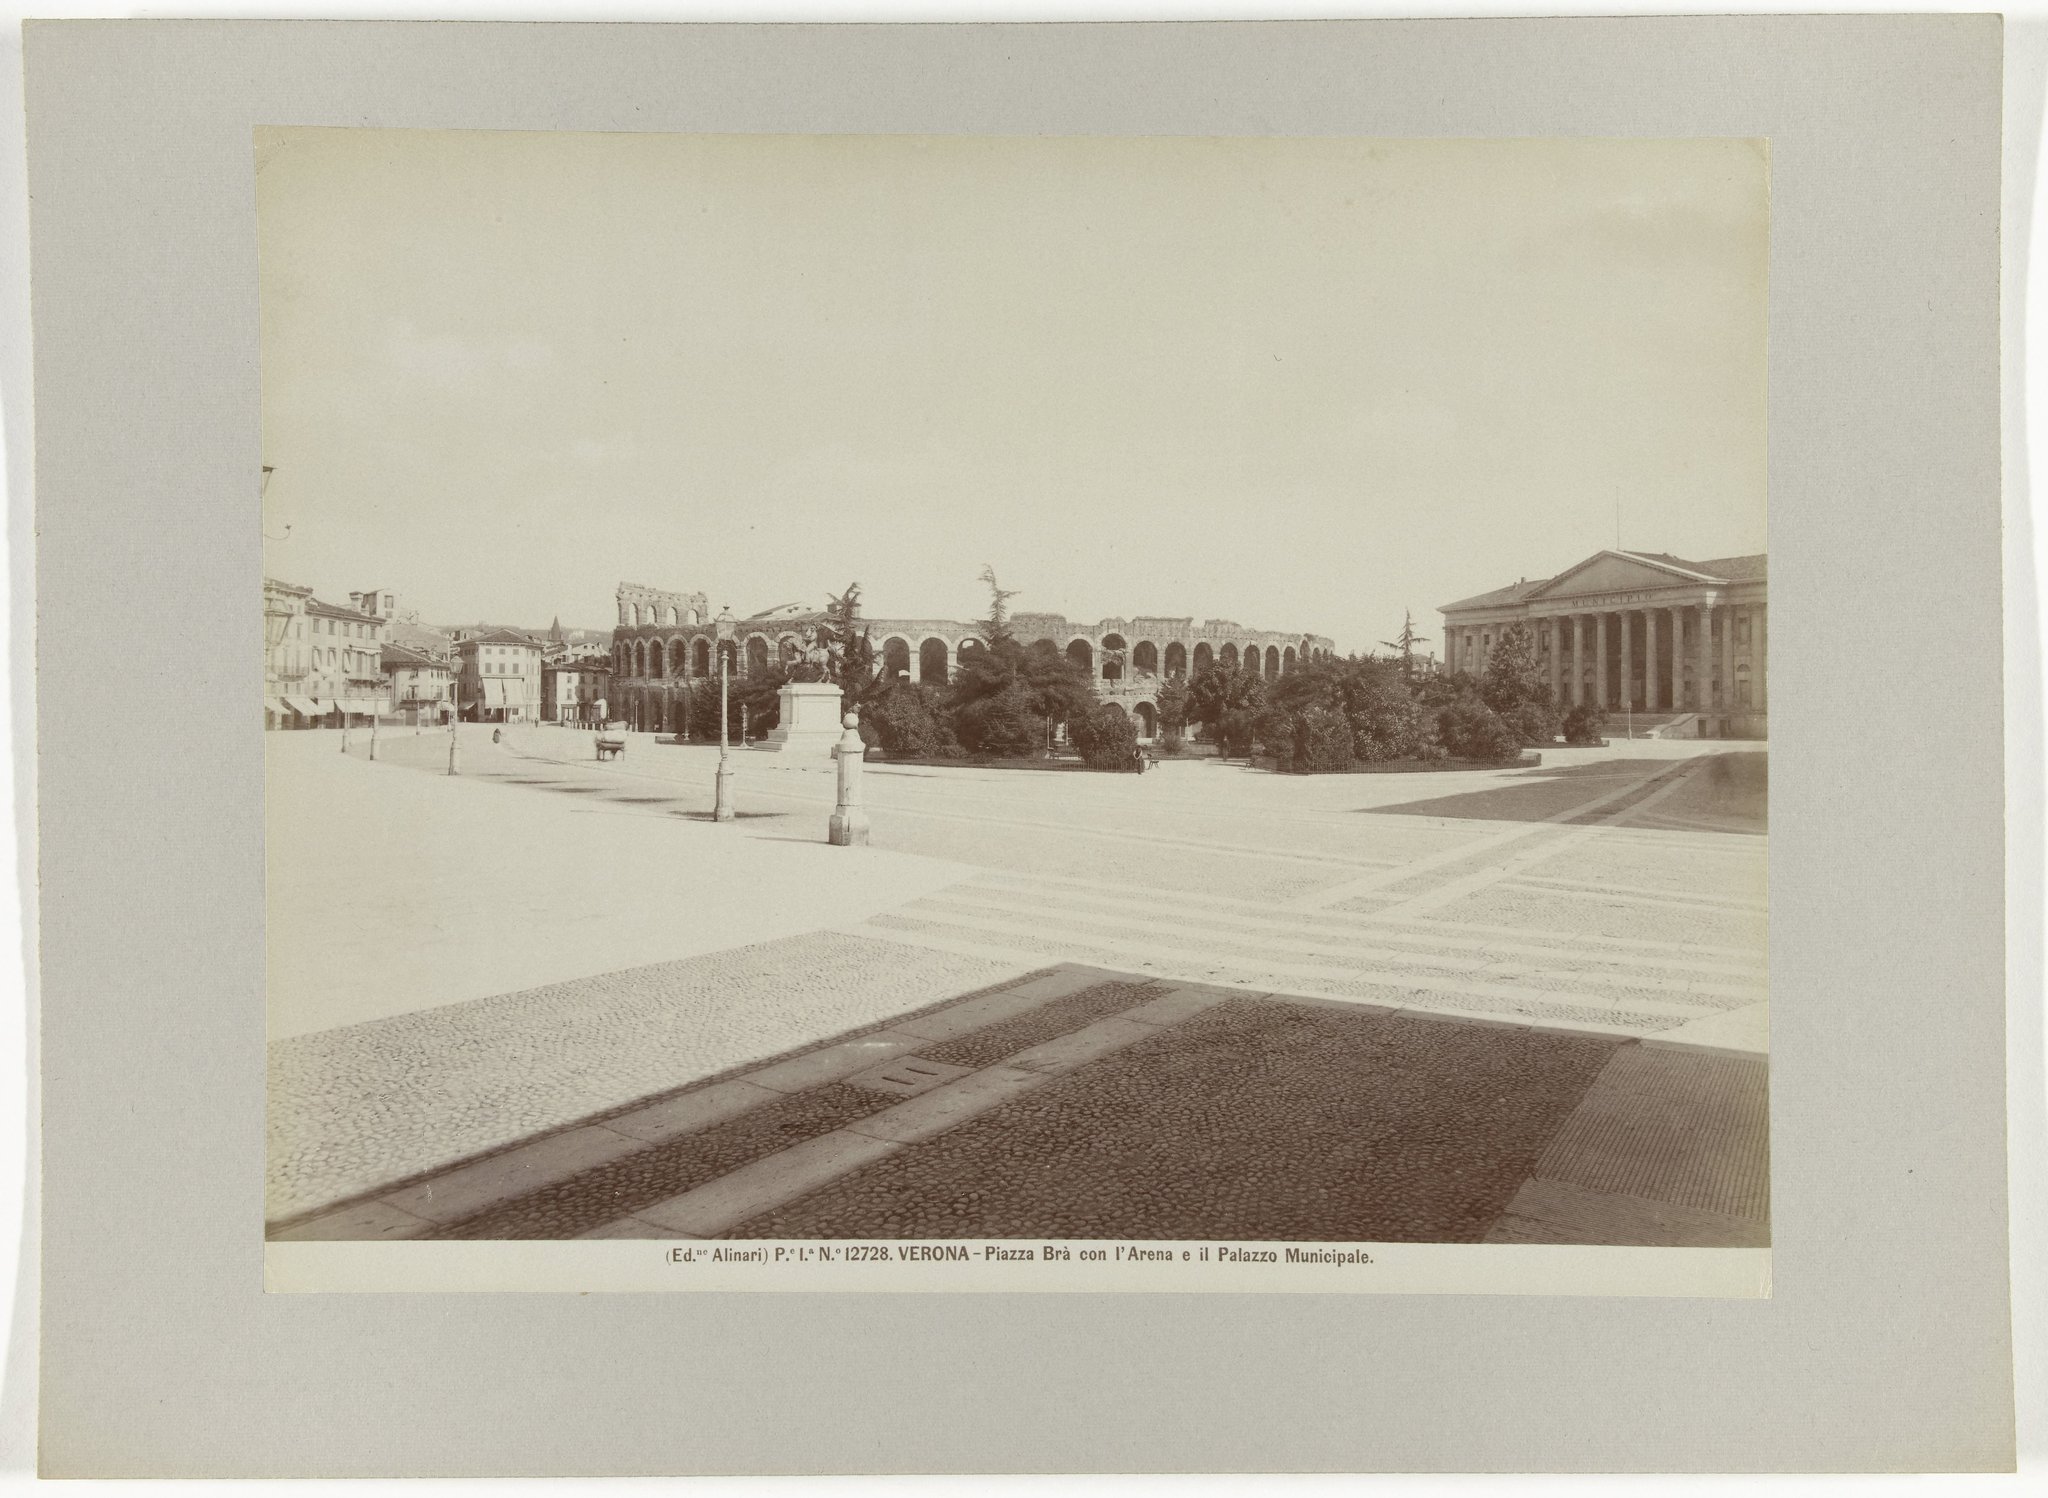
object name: photograph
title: P.e 1.a N.o 12728. VERONA - Piazza Brà con l'Arena e il Palazzo Municipale.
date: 1880-1895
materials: cardboard, paper, photographic support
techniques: albumen print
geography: florence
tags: square, place, circus, etc.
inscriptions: number: ‘86.’